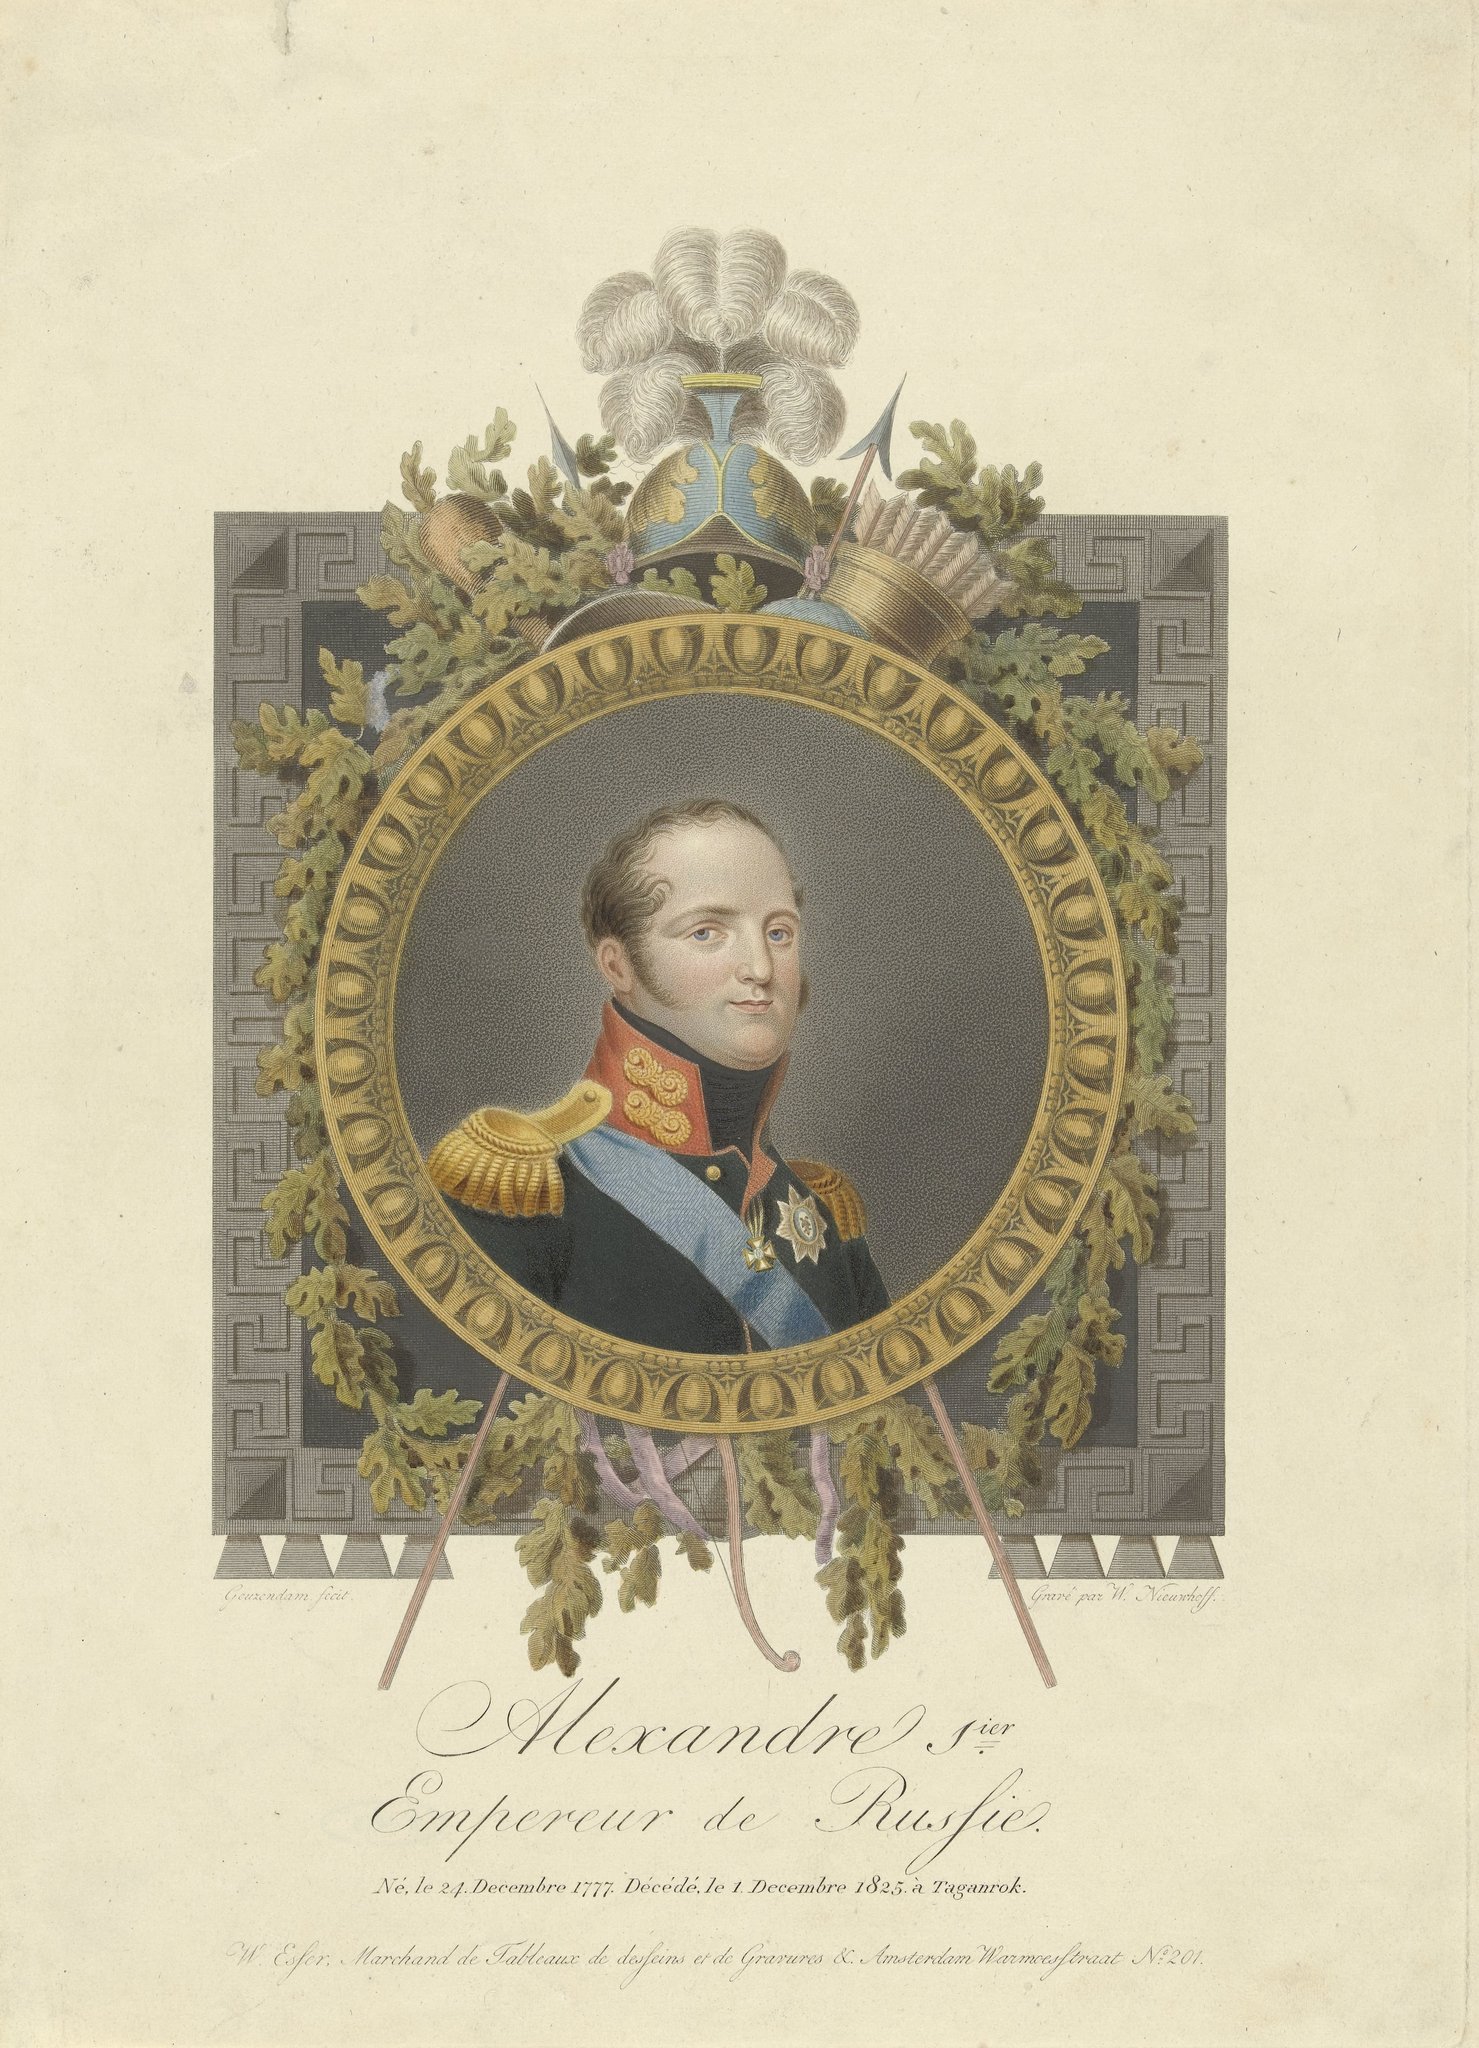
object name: print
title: Portret van tsaar Alexander I van Rusland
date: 1825-1827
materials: paper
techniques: engraving, hand coloring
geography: amsterdam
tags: alexander i (tsaar van rusland), helmet, archer's weapons: bow and arrow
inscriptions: collector's mark: Lugt 2228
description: Portret van Alexander I, tsaar van Rusland, gekleed in een jas met ringkraag, epauletten en een sjerp. Buste naar rechts in een cirkelvormige lijst. De lijst wordt bekroond met een helm. In de randversiering zijn pijlen, een pijlenkoker en een boog verwerkt. Onderaan in de marge zijn titel, geboorte- en sterfdata in het Frans.